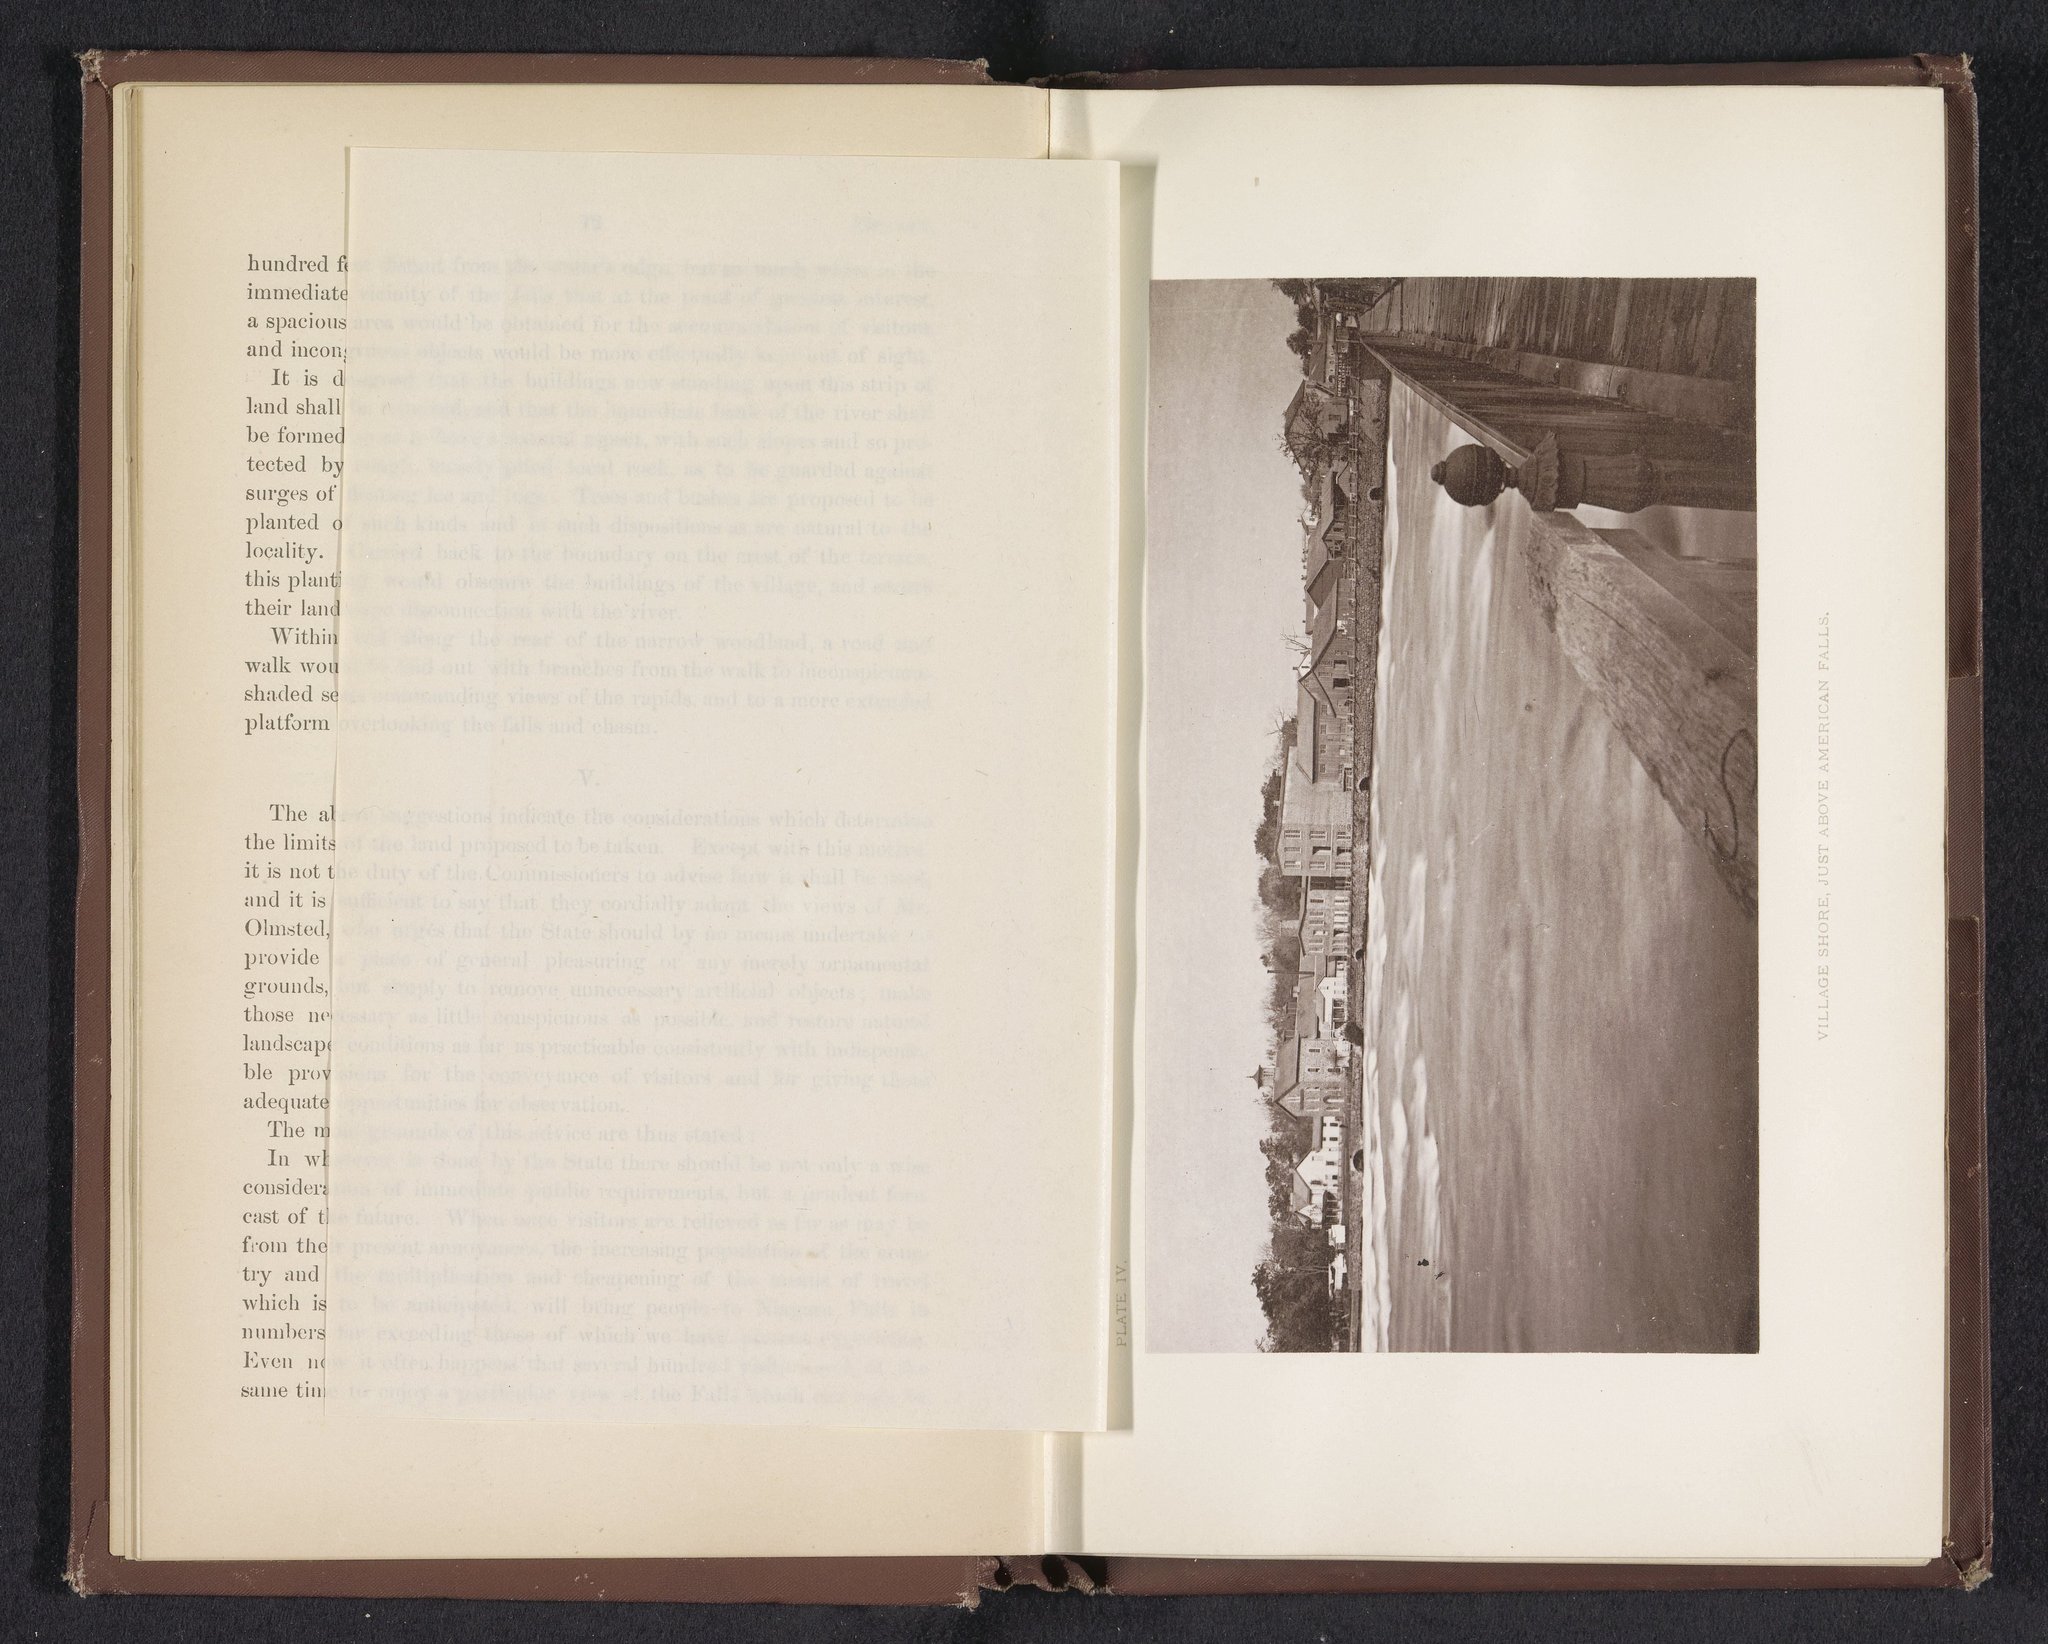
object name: photomechanical print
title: Village shore, Just above American Falls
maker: george barker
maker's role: fotograaf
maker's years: 1844-1894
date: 1870-1880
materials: paper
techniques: photograph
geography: boston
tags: prospect of village, silhouette of village, river bank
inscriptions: number: ‘Plate IV.’